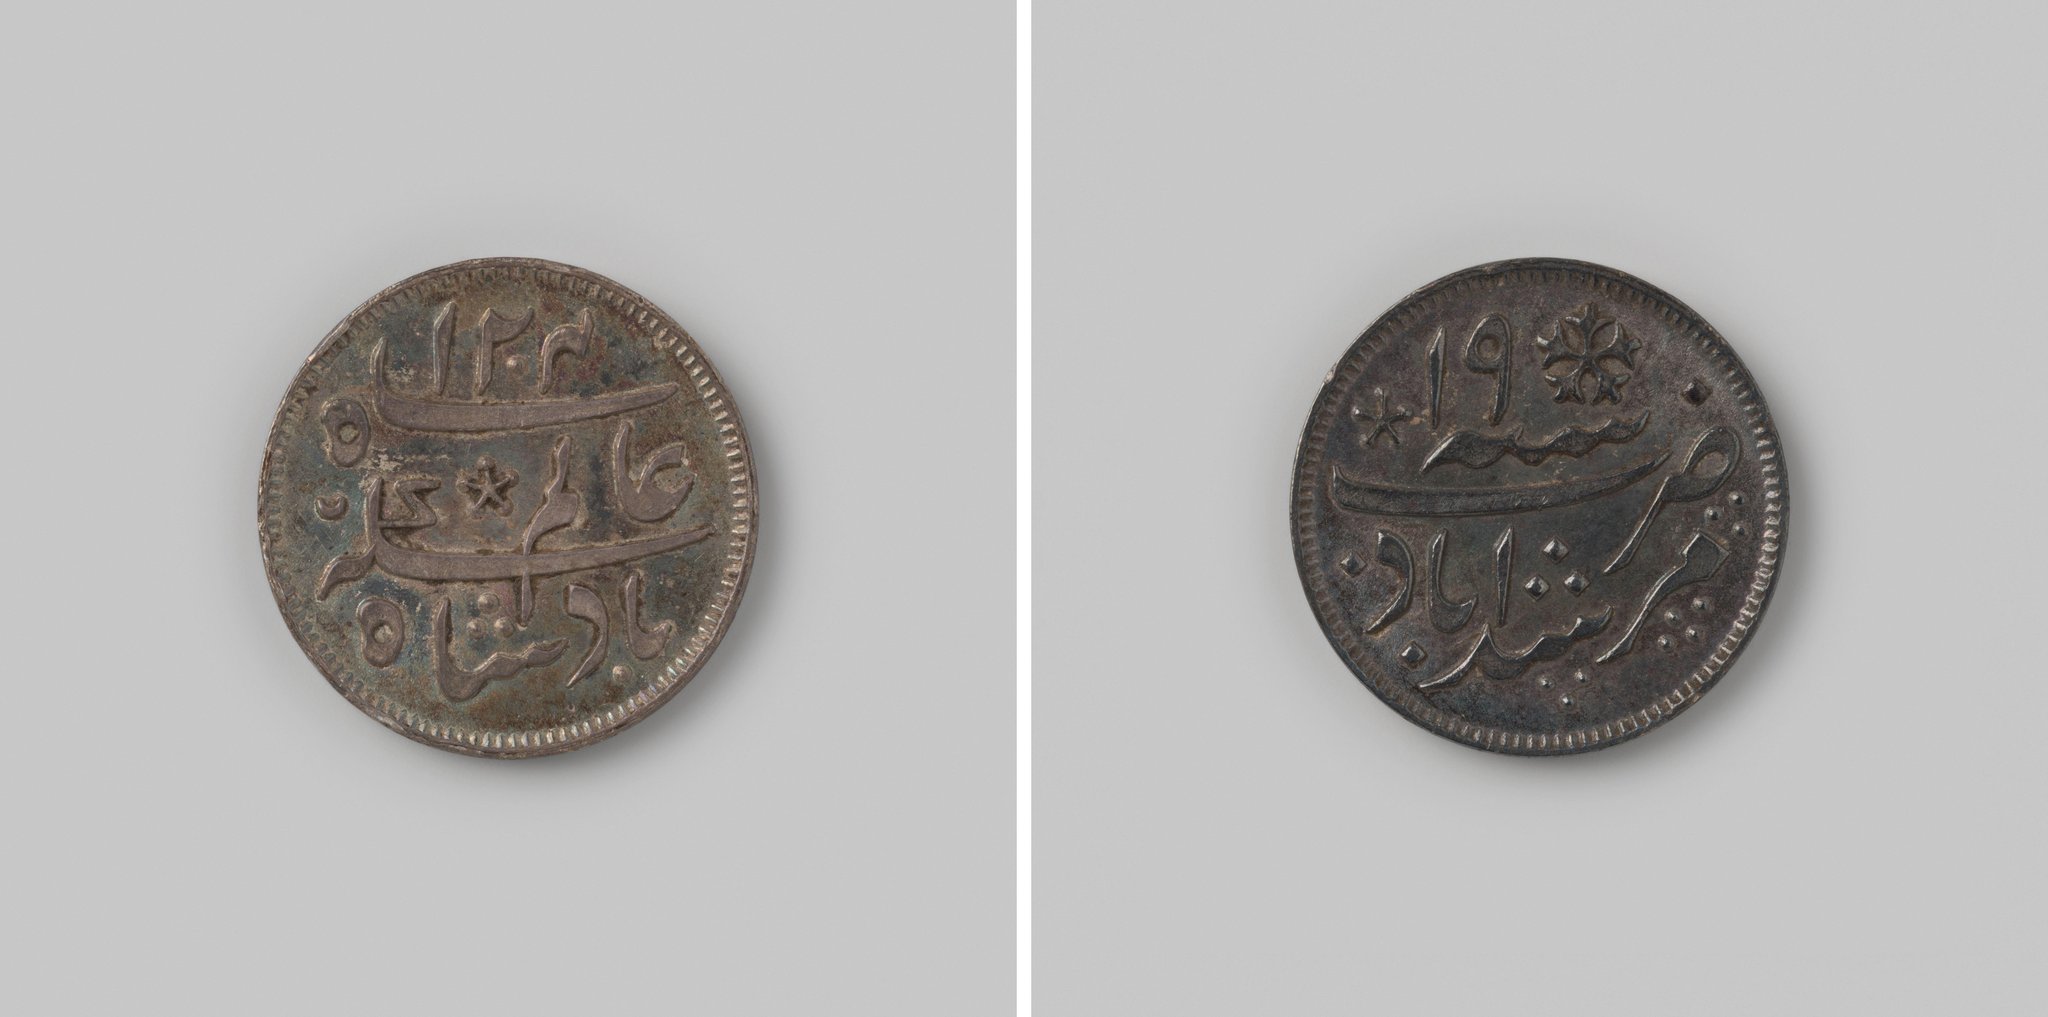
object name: coin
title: 1/4 roepie uit Bengalen in India van de Engelse Oostindische Compagnie (EIC) op naam van Sjah Alam I, 1202 [=1788] en regeringsjaar 19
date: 1830-1833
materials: silver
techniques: striking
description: Zilveren munt. Voorzijde: in Arabische lettertekens in twee regels opschrift. Bovenaan jaartal:1202 [=1788]. Keerzijde: in Arabische lettertekens in twee regels opschrift. Bovenaan aanduiding van het "eeuwige" regeringsjaar: 19. Gladde rand.